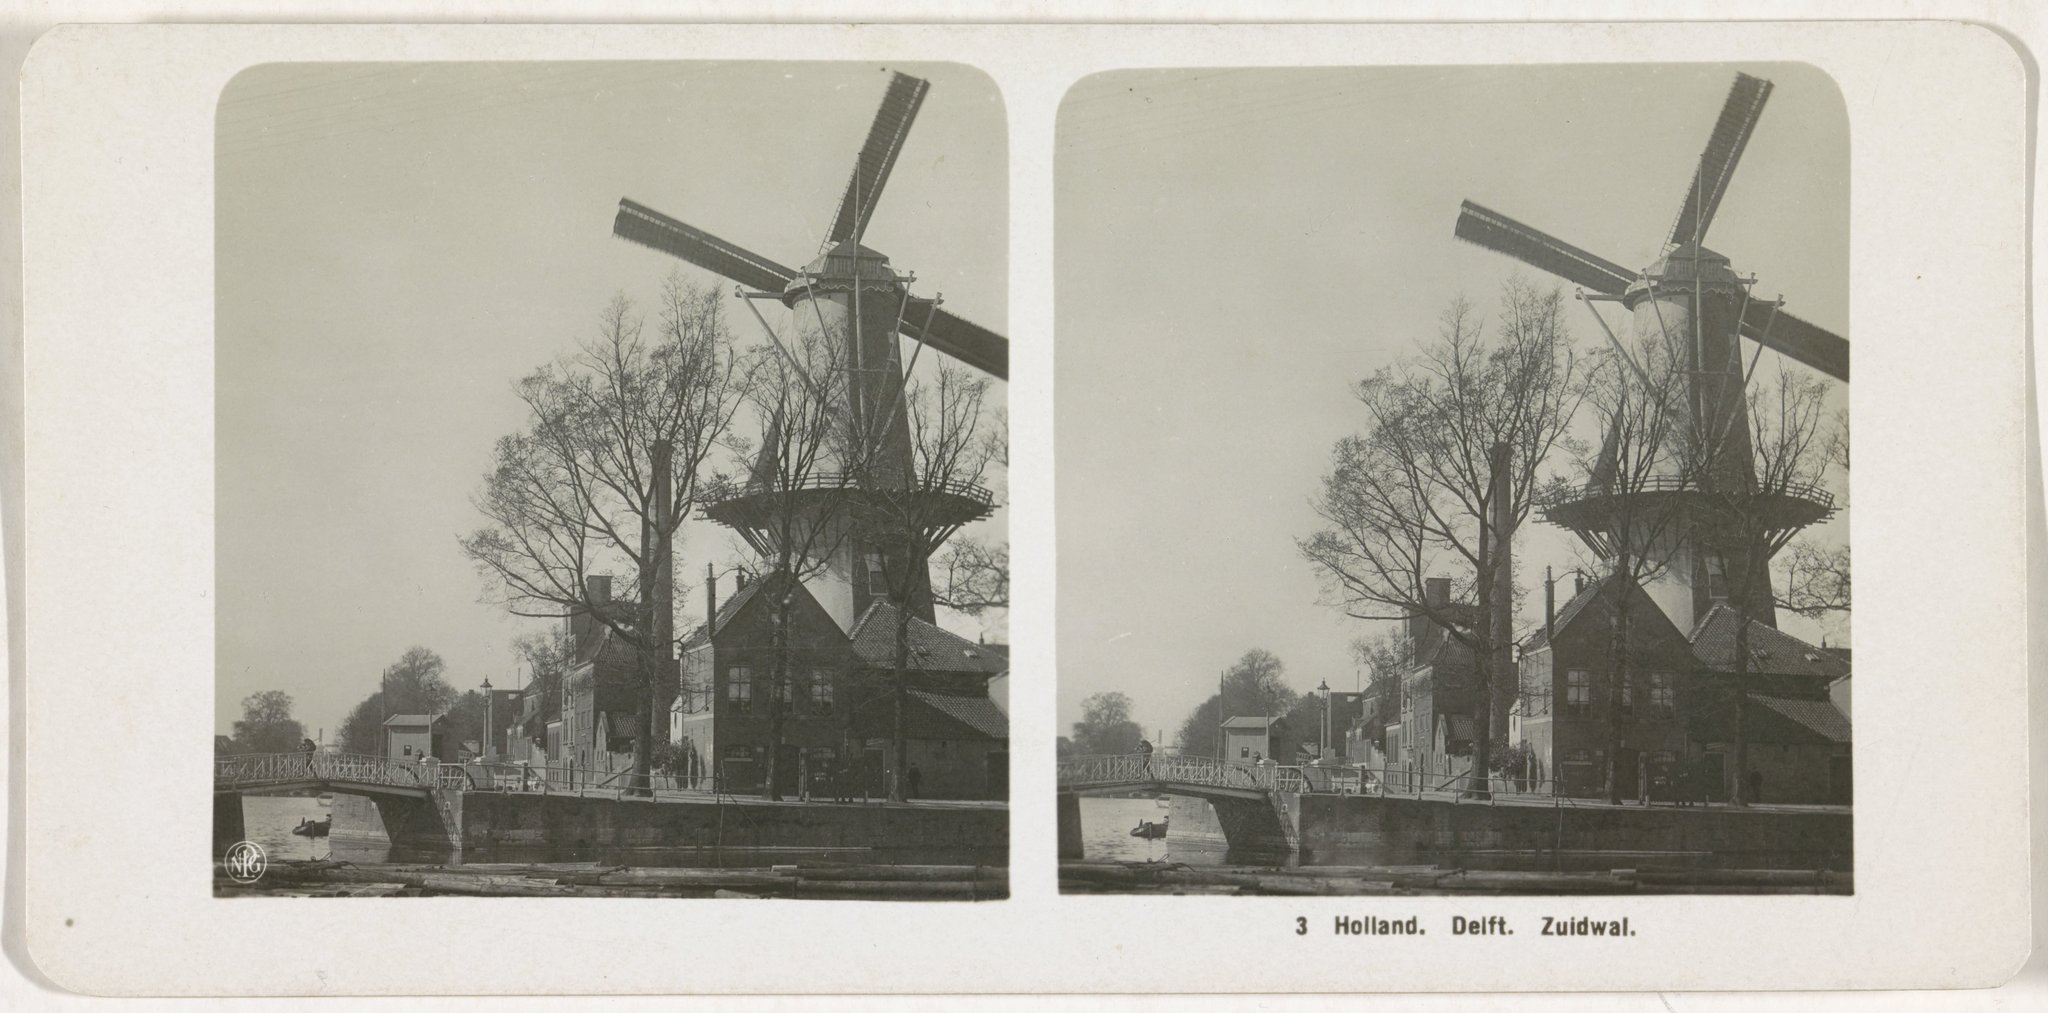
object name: stereograph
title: 3 Holland. Delft. Zuidwal.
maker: ngp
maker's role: fotograaf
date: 1900-1940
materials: cardboard, paper, photographic support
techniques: gelatin silver print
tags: delft